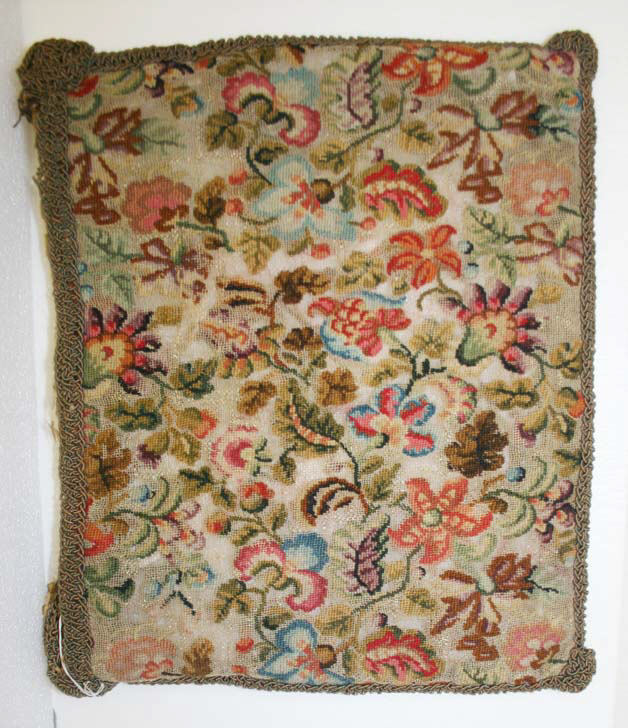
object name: drawstring bag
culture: austrian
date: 1800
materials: silk, wool